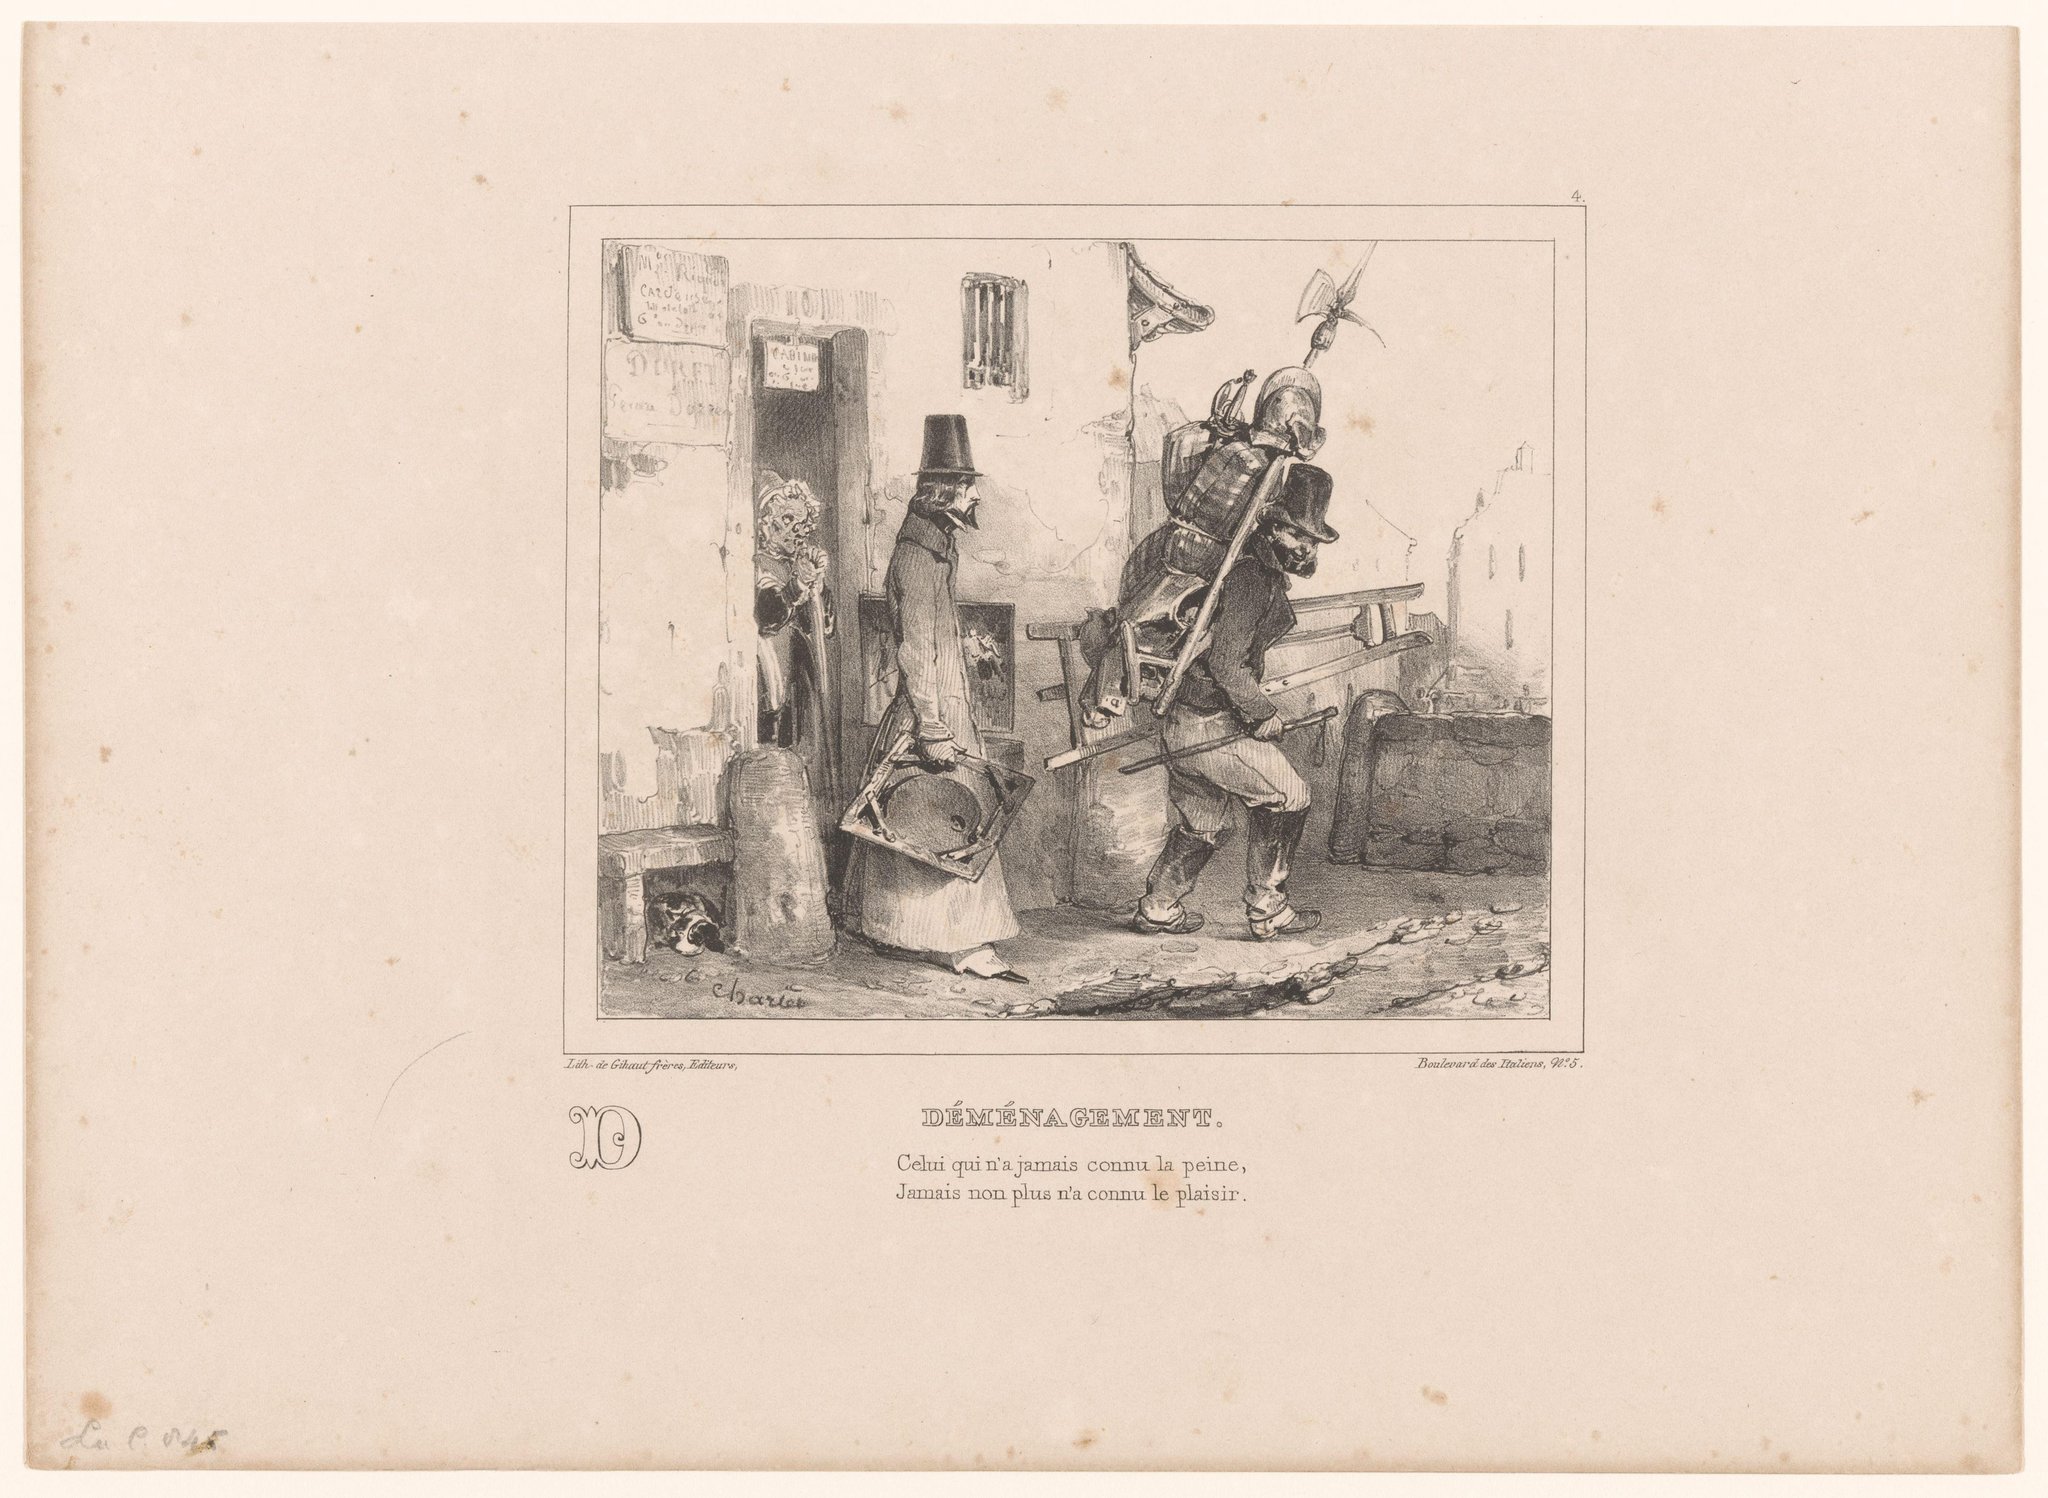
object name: print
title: Verhuizing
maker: nicolas toussaint charlet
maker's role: draughtsman, painter, print maker, printer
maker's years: 1792-1845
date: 1835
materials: paper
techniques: lithograph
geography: paris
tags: moving (house), bohemian life of artist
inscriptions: collector's mark: Lugt 2228a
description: Een jonge schilder verlaat zijn huis met tegenzin. De verhuizer voor hem lacht vrolijk, ondanks de zware last op zijn rug. Wie nooit moeite heeft gekend, heeft ook nooit het plezier gekend.